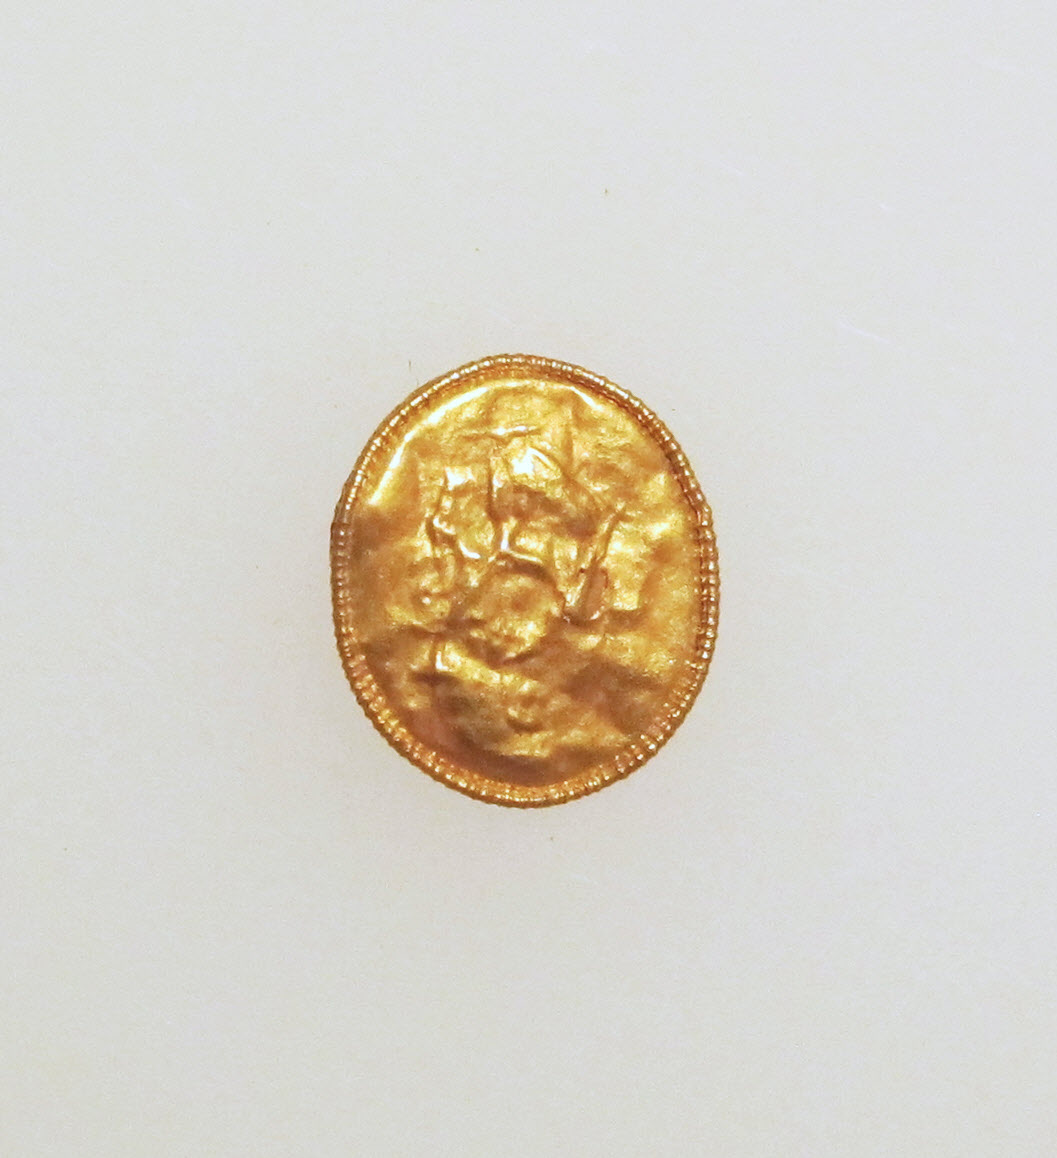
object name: roundel, disk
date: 400-301 BCE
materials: gold